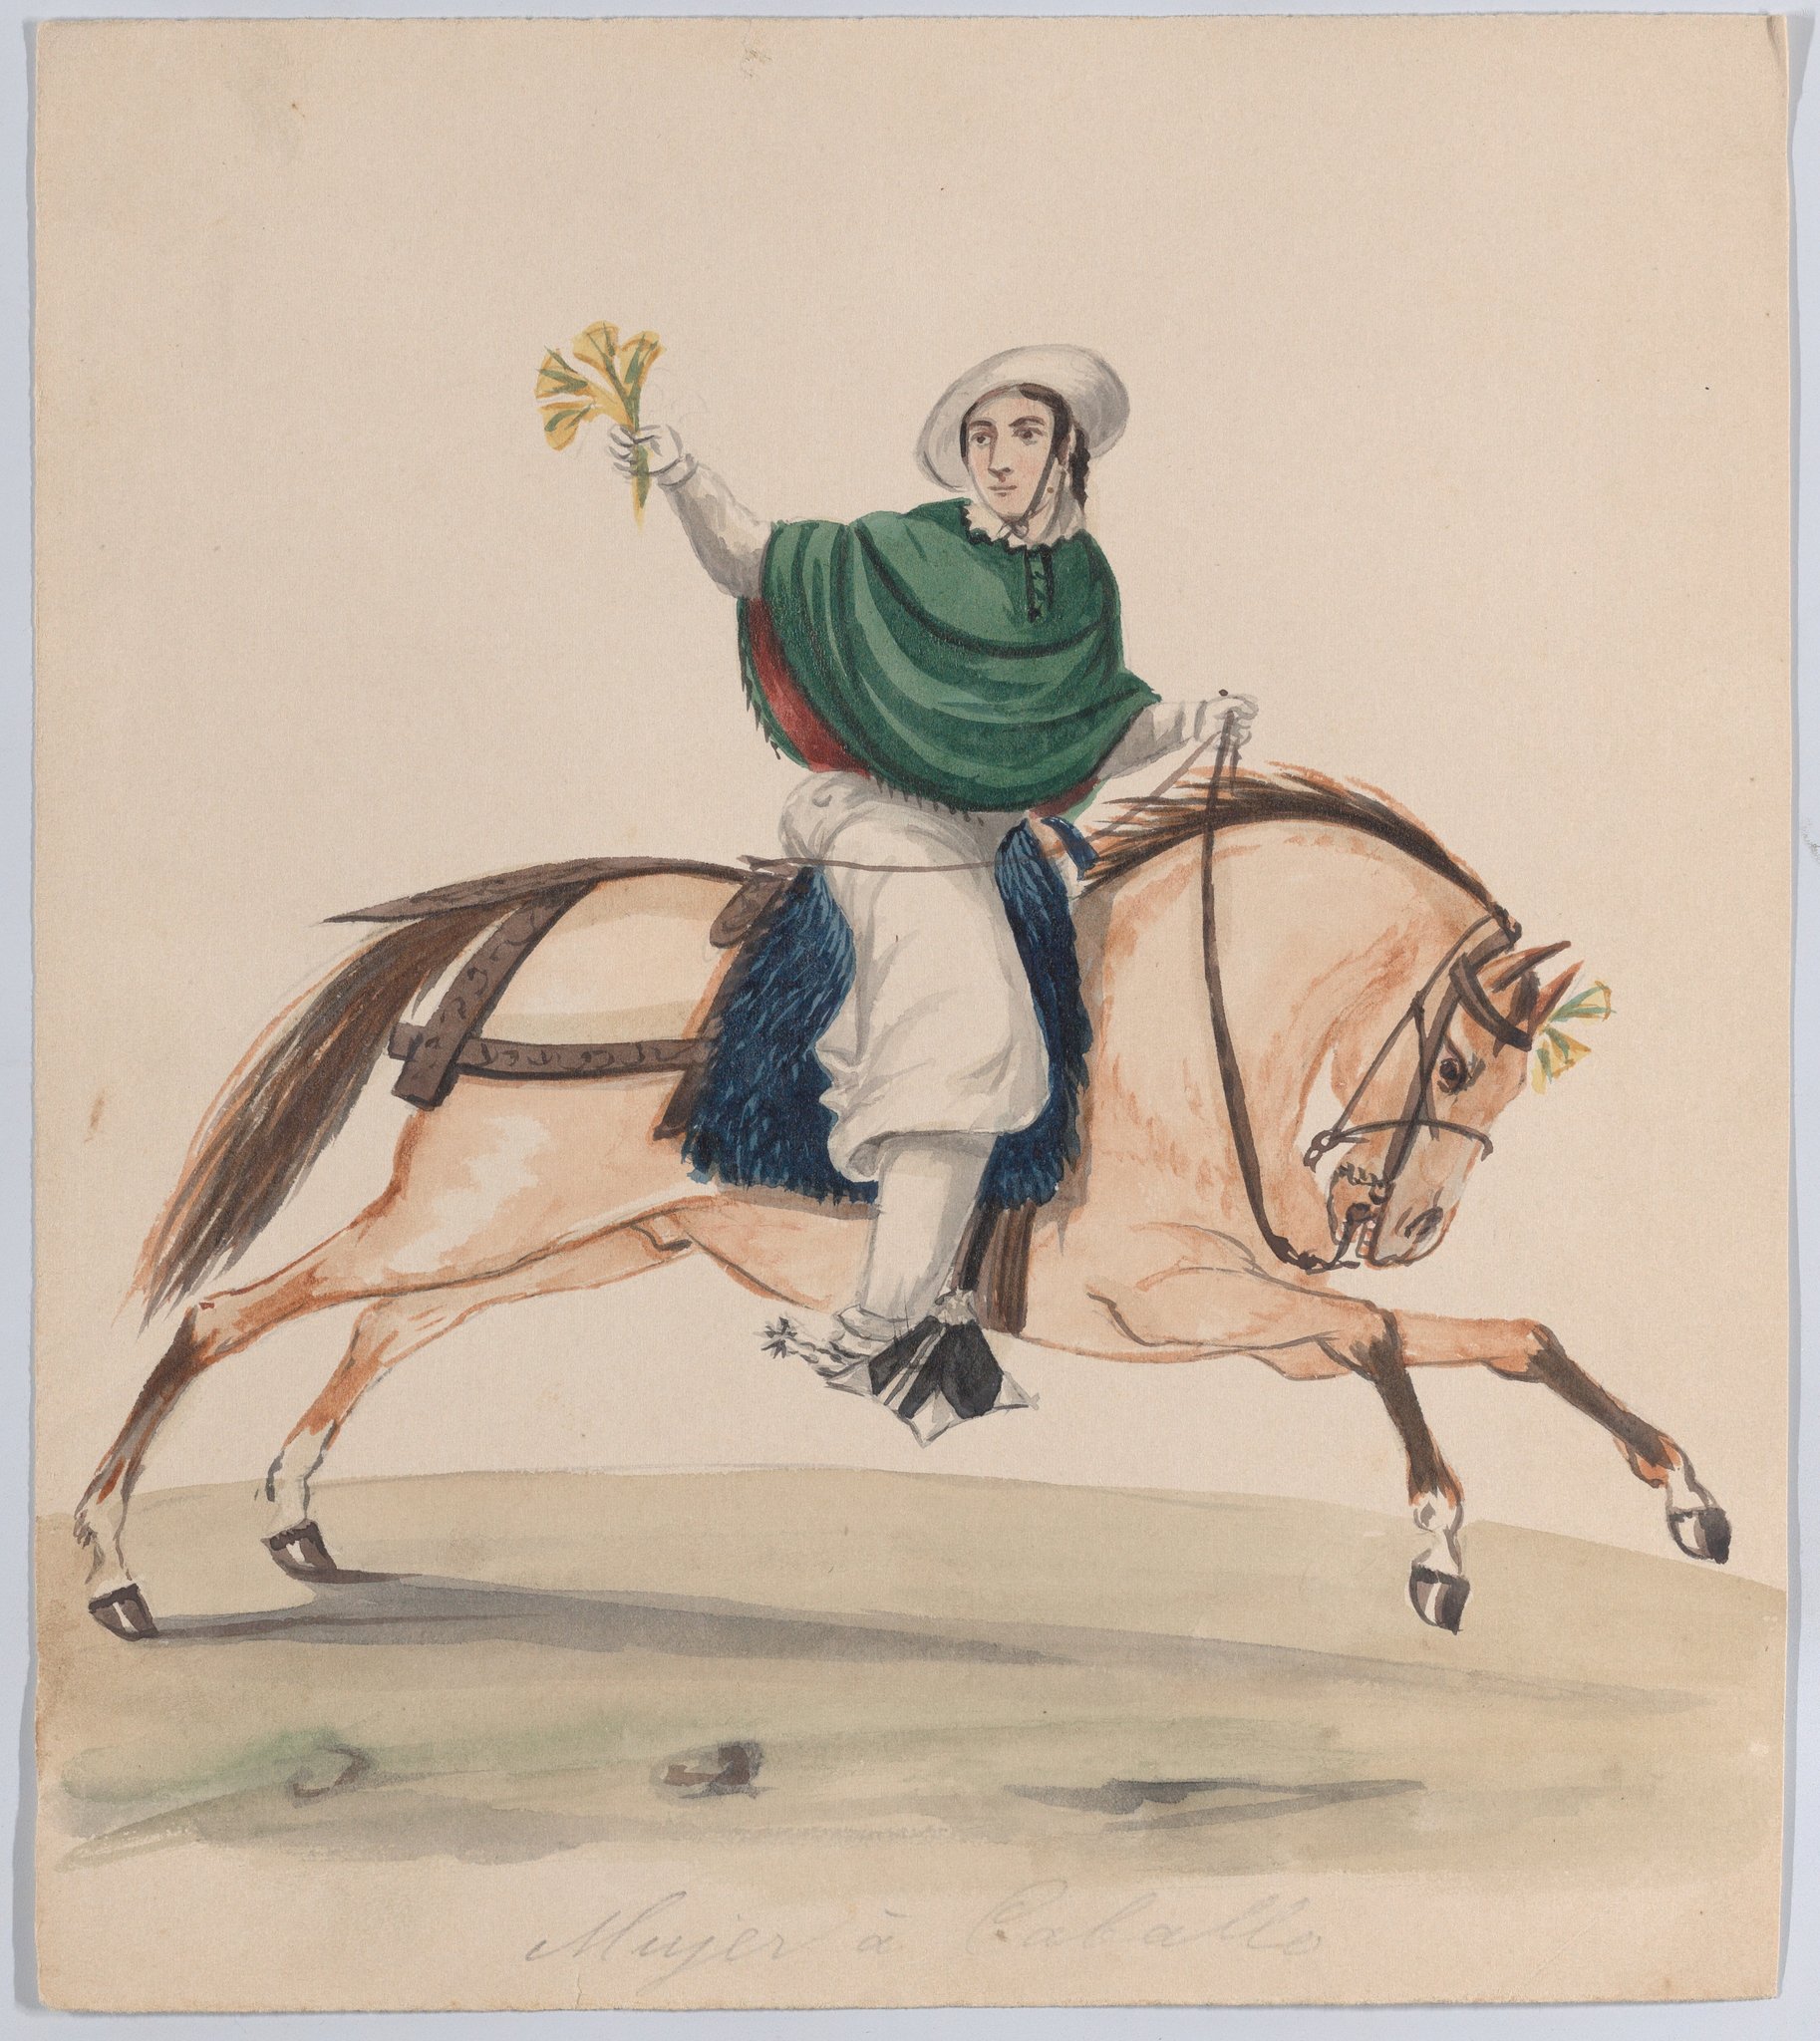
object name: drawing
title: An elegantly dressed woman on horseback, from a group of drawings depicting Peruvian dress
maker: francisco (pancho) fierro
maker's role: artist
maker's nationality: african peruvian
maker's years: 1807-1879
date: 1848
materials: watercolor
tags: men,women